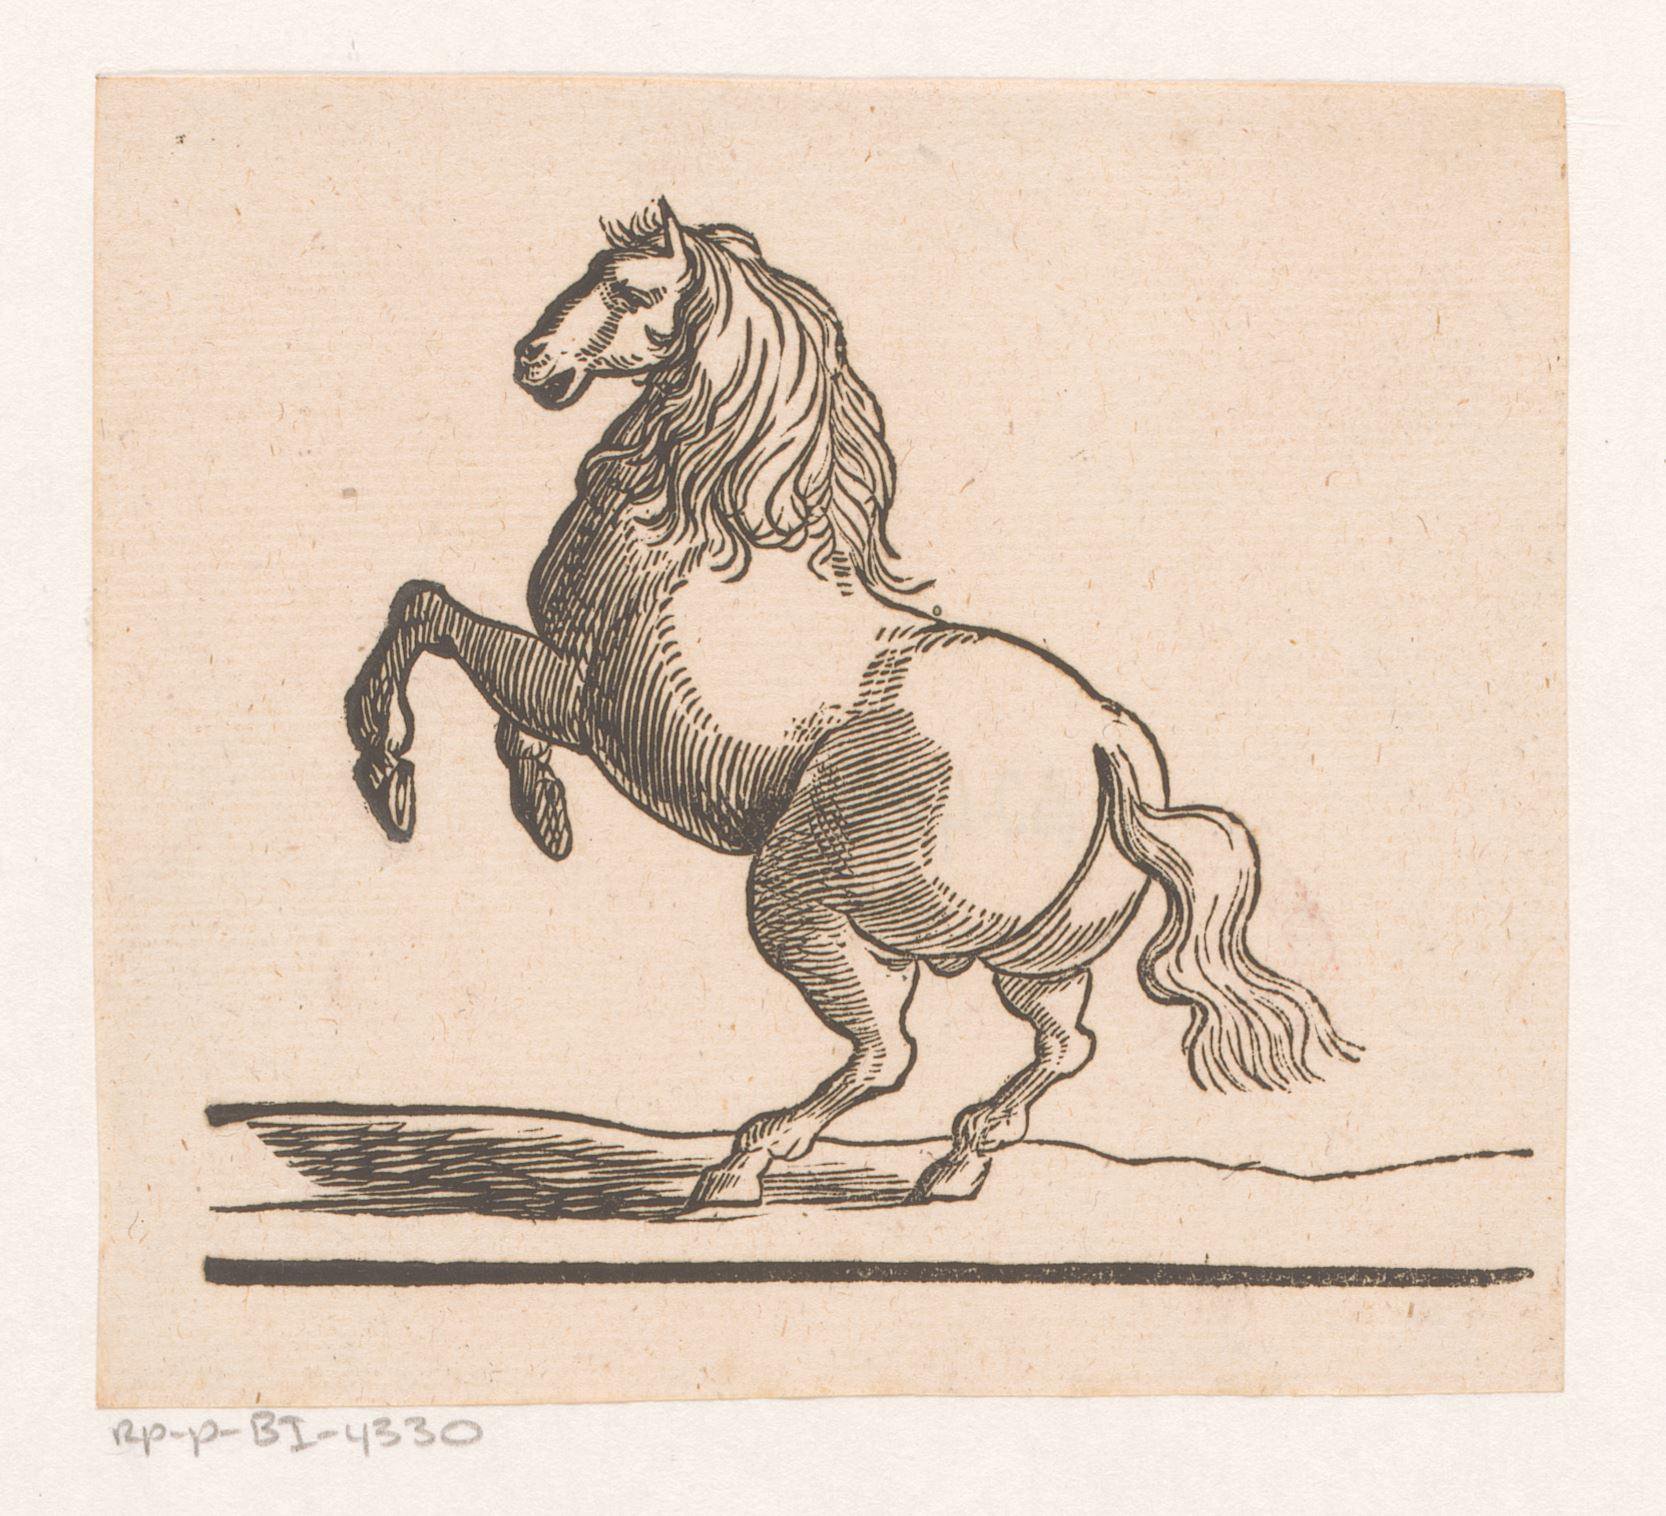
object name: print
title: Steigerend paard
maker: Anonymous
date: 1600-1699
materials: paper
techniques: woodcut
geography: netherlands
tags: horse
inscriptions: collector's mark: Lugt 240